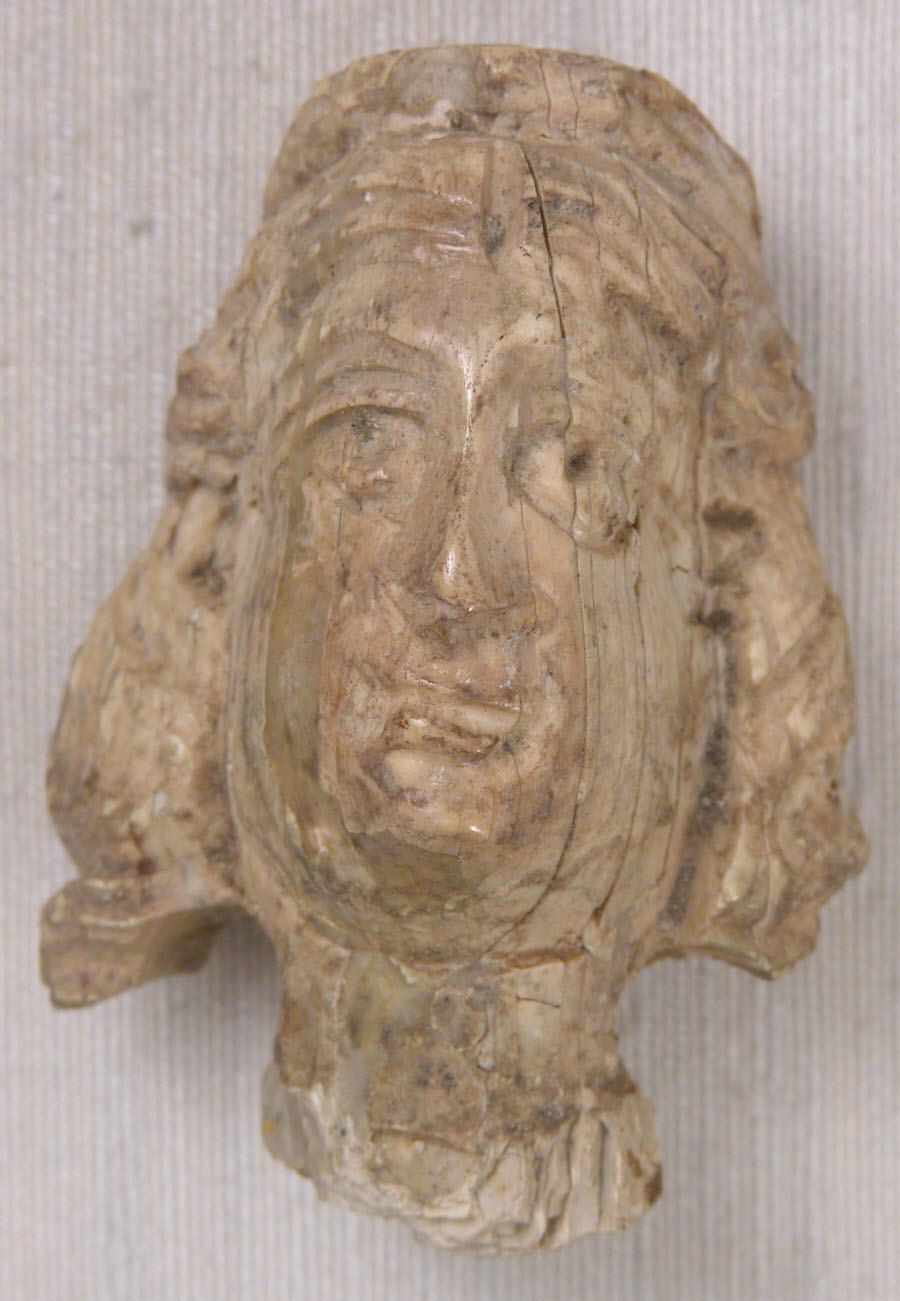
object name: head of a figure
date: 201-500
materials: ivory, wood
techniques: carving, incising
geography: egypt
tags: heads